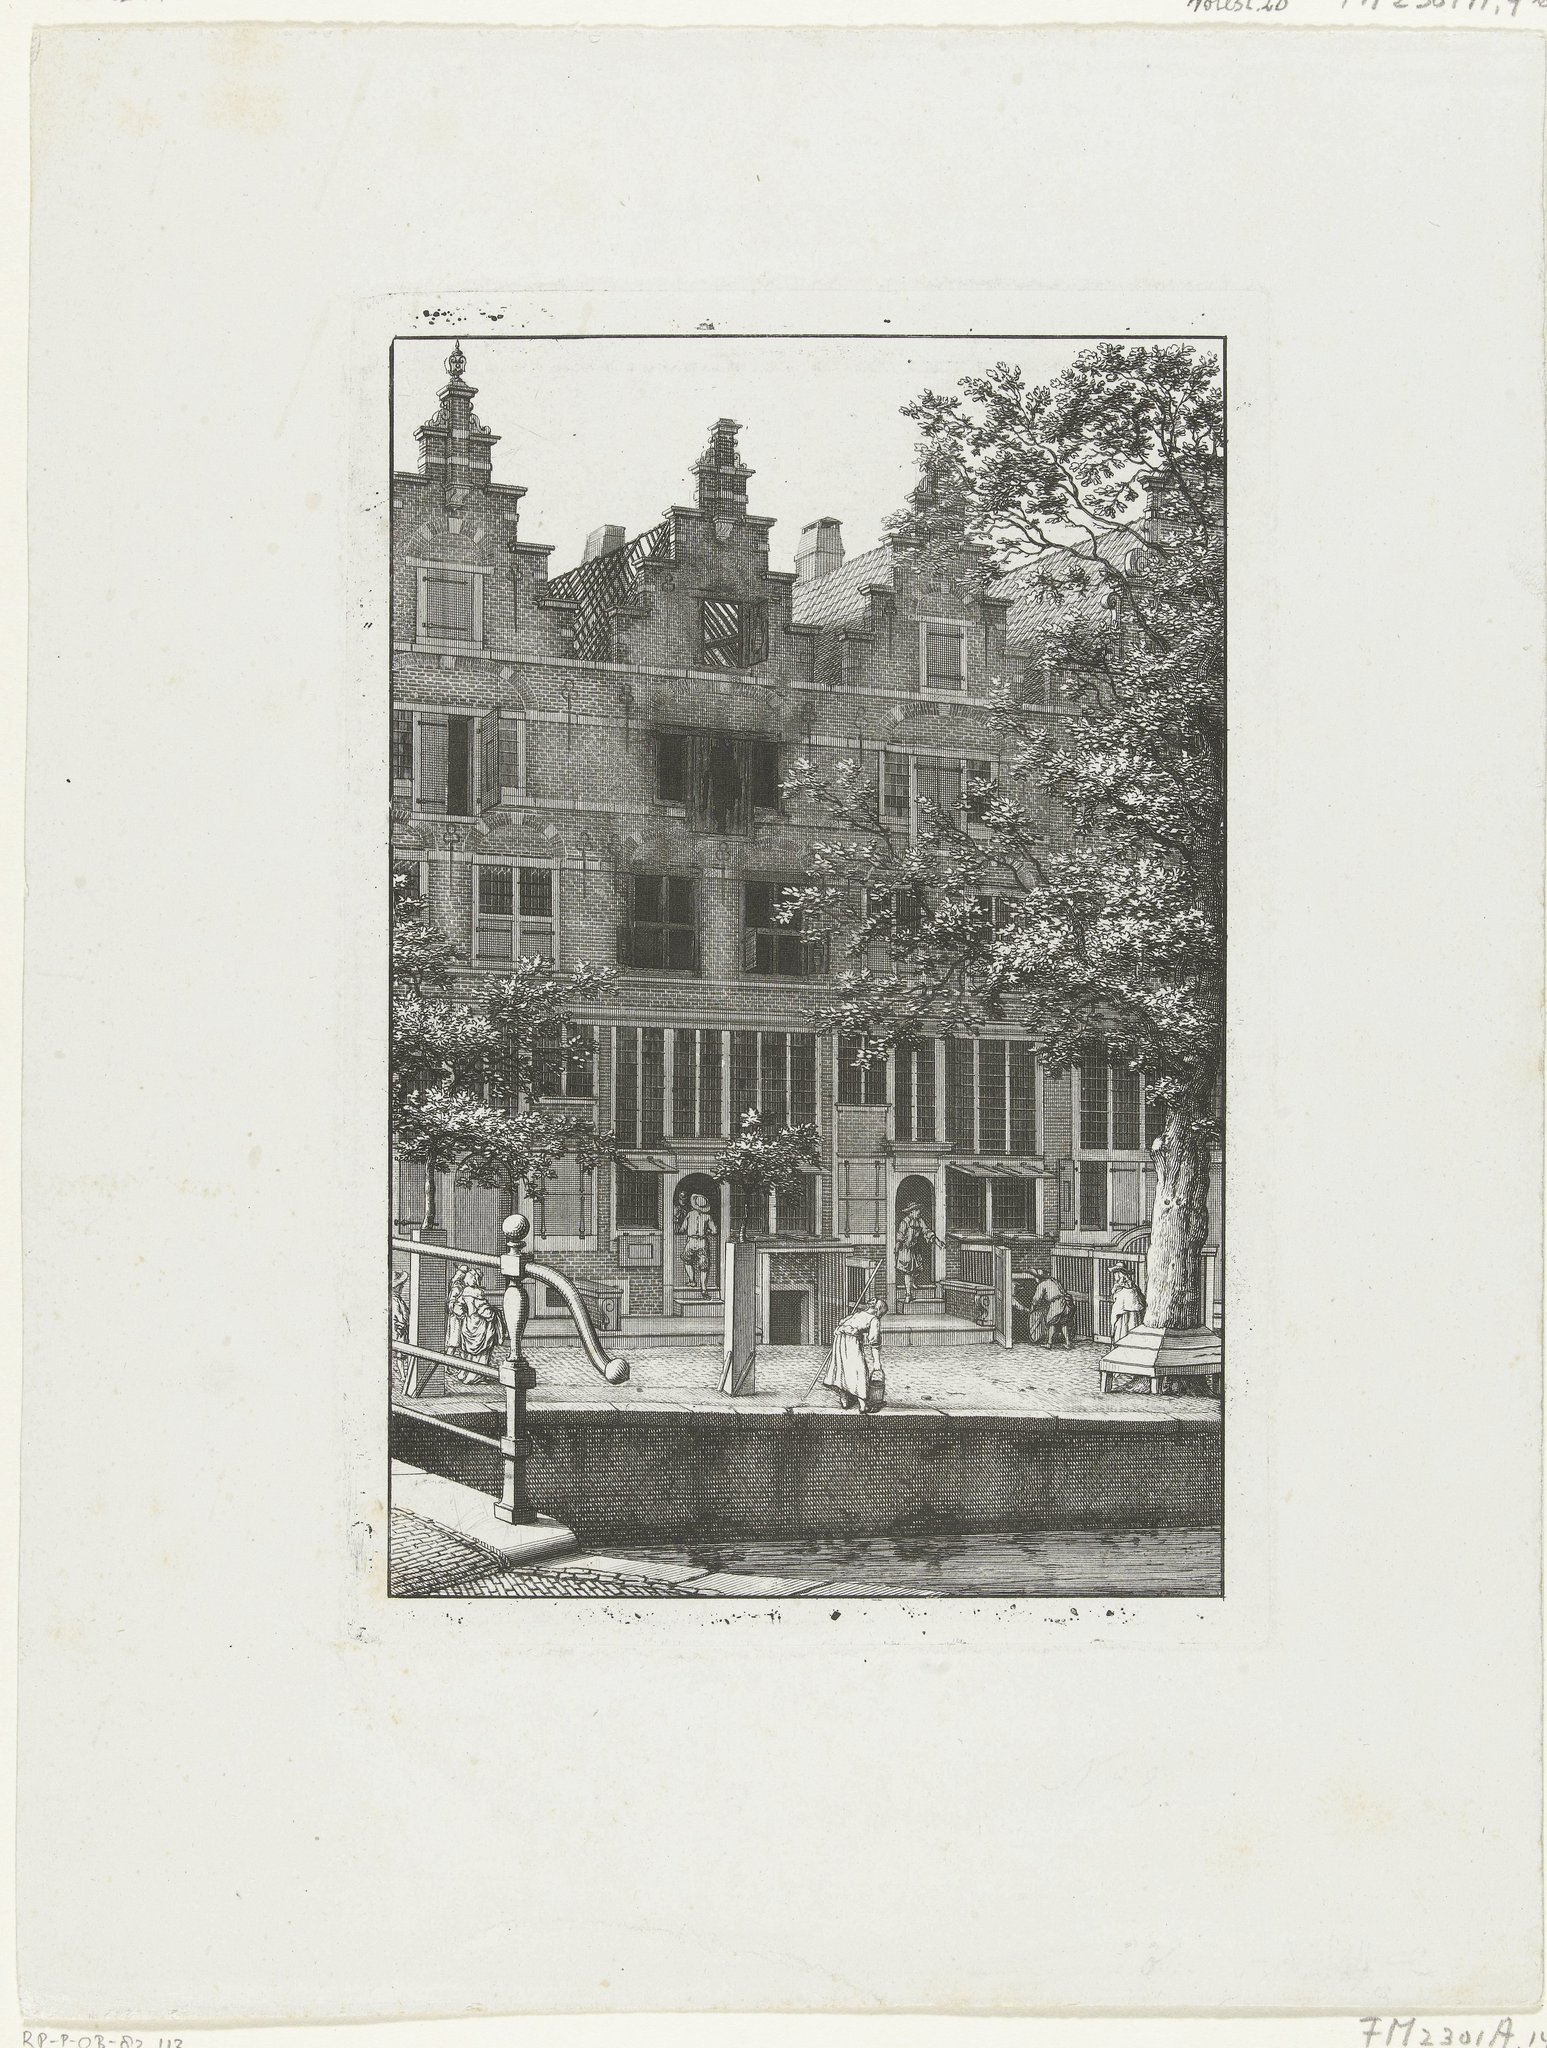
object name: print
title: Uitgebrand huis op de Herengracht, 1683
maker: Anonymous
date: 1690-1699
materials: paper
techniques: etching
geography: northern netherlands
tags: amsterdam, painter, draughtsman, jan van der heyden, fire-extinguishing equipment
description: Een huis op de Herengracht waar in de nacht van 25 op 26 april 1683 brand gewoed heeft, maar dat door tijdig blussen behouden is gebleven. Links ligt de brug voor de Hartenstraat.